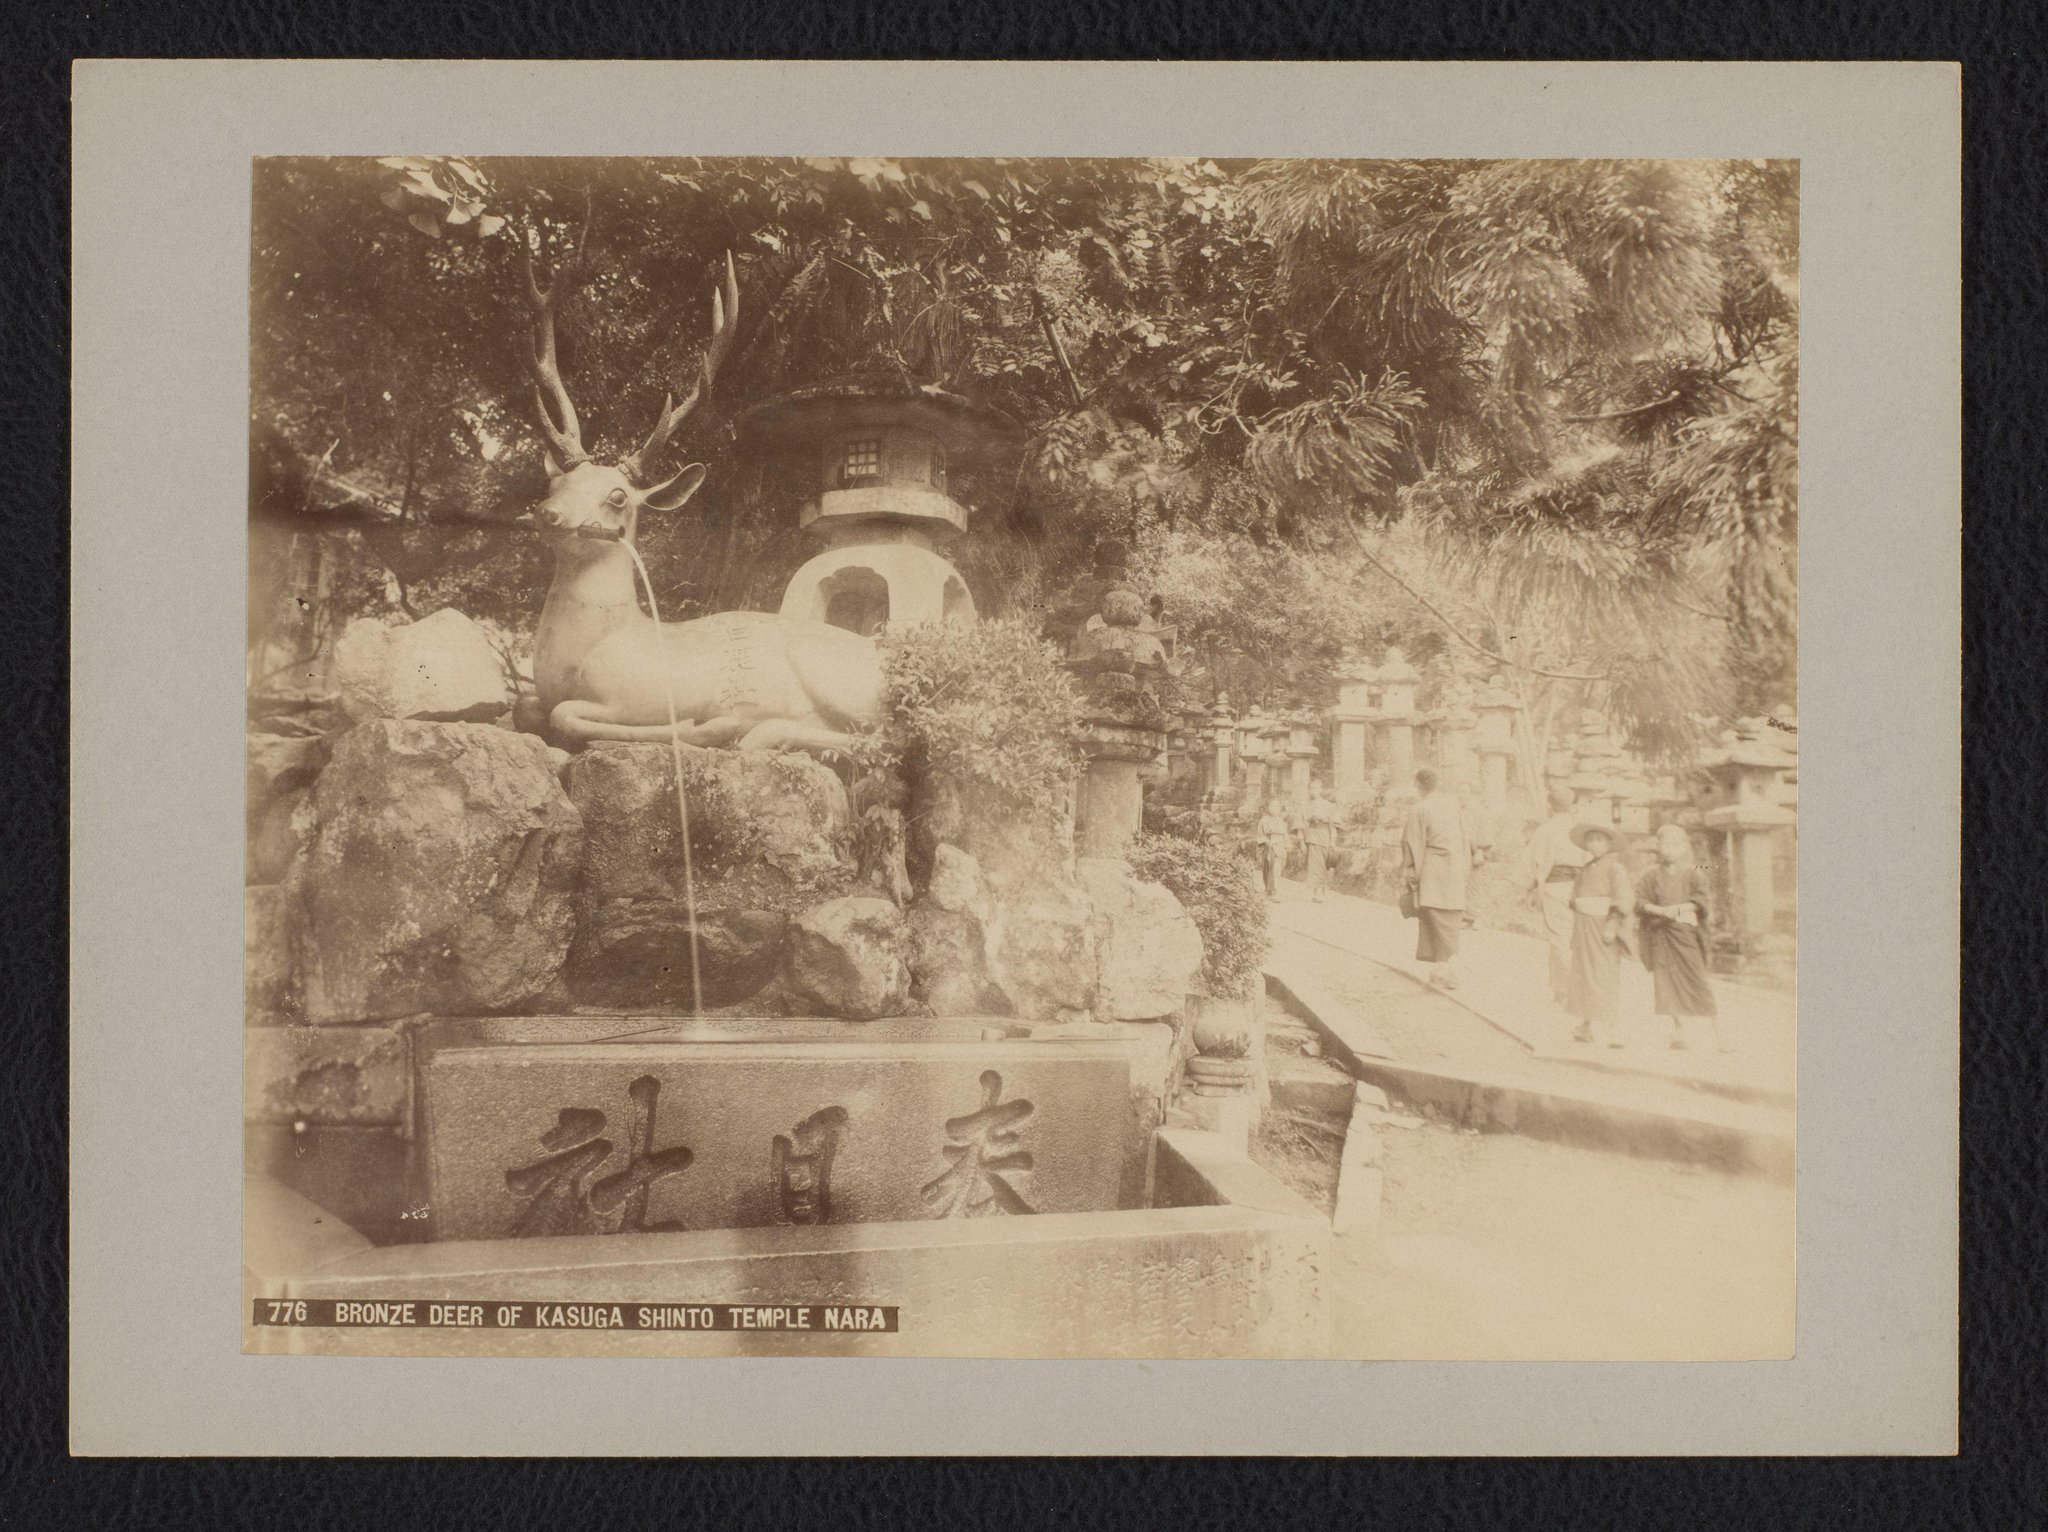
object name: photograph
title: 776 Bronze deer of Kasuga Shinto Temple Nara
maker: Anonymous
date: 1895-1915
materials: cardboard, photographic support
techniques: albumen print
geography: nara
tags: nara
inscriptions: number: ‘14.’